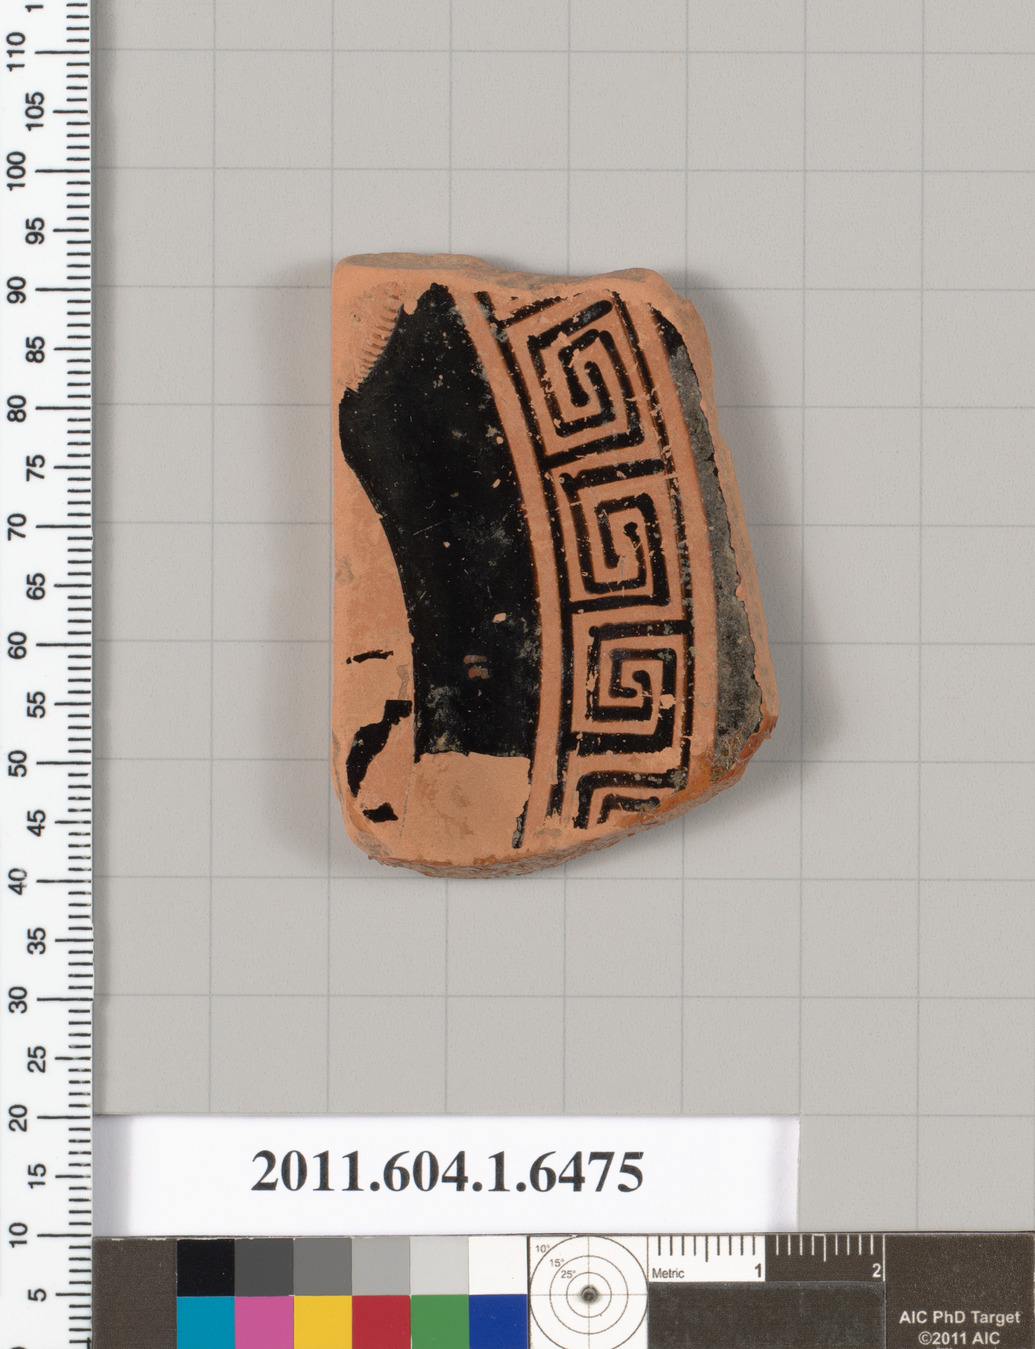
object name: kylix fragment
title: Terracotta fragment of a kylix (drinking cup)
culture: greek, attic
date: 490-480 BCE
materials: terracotta